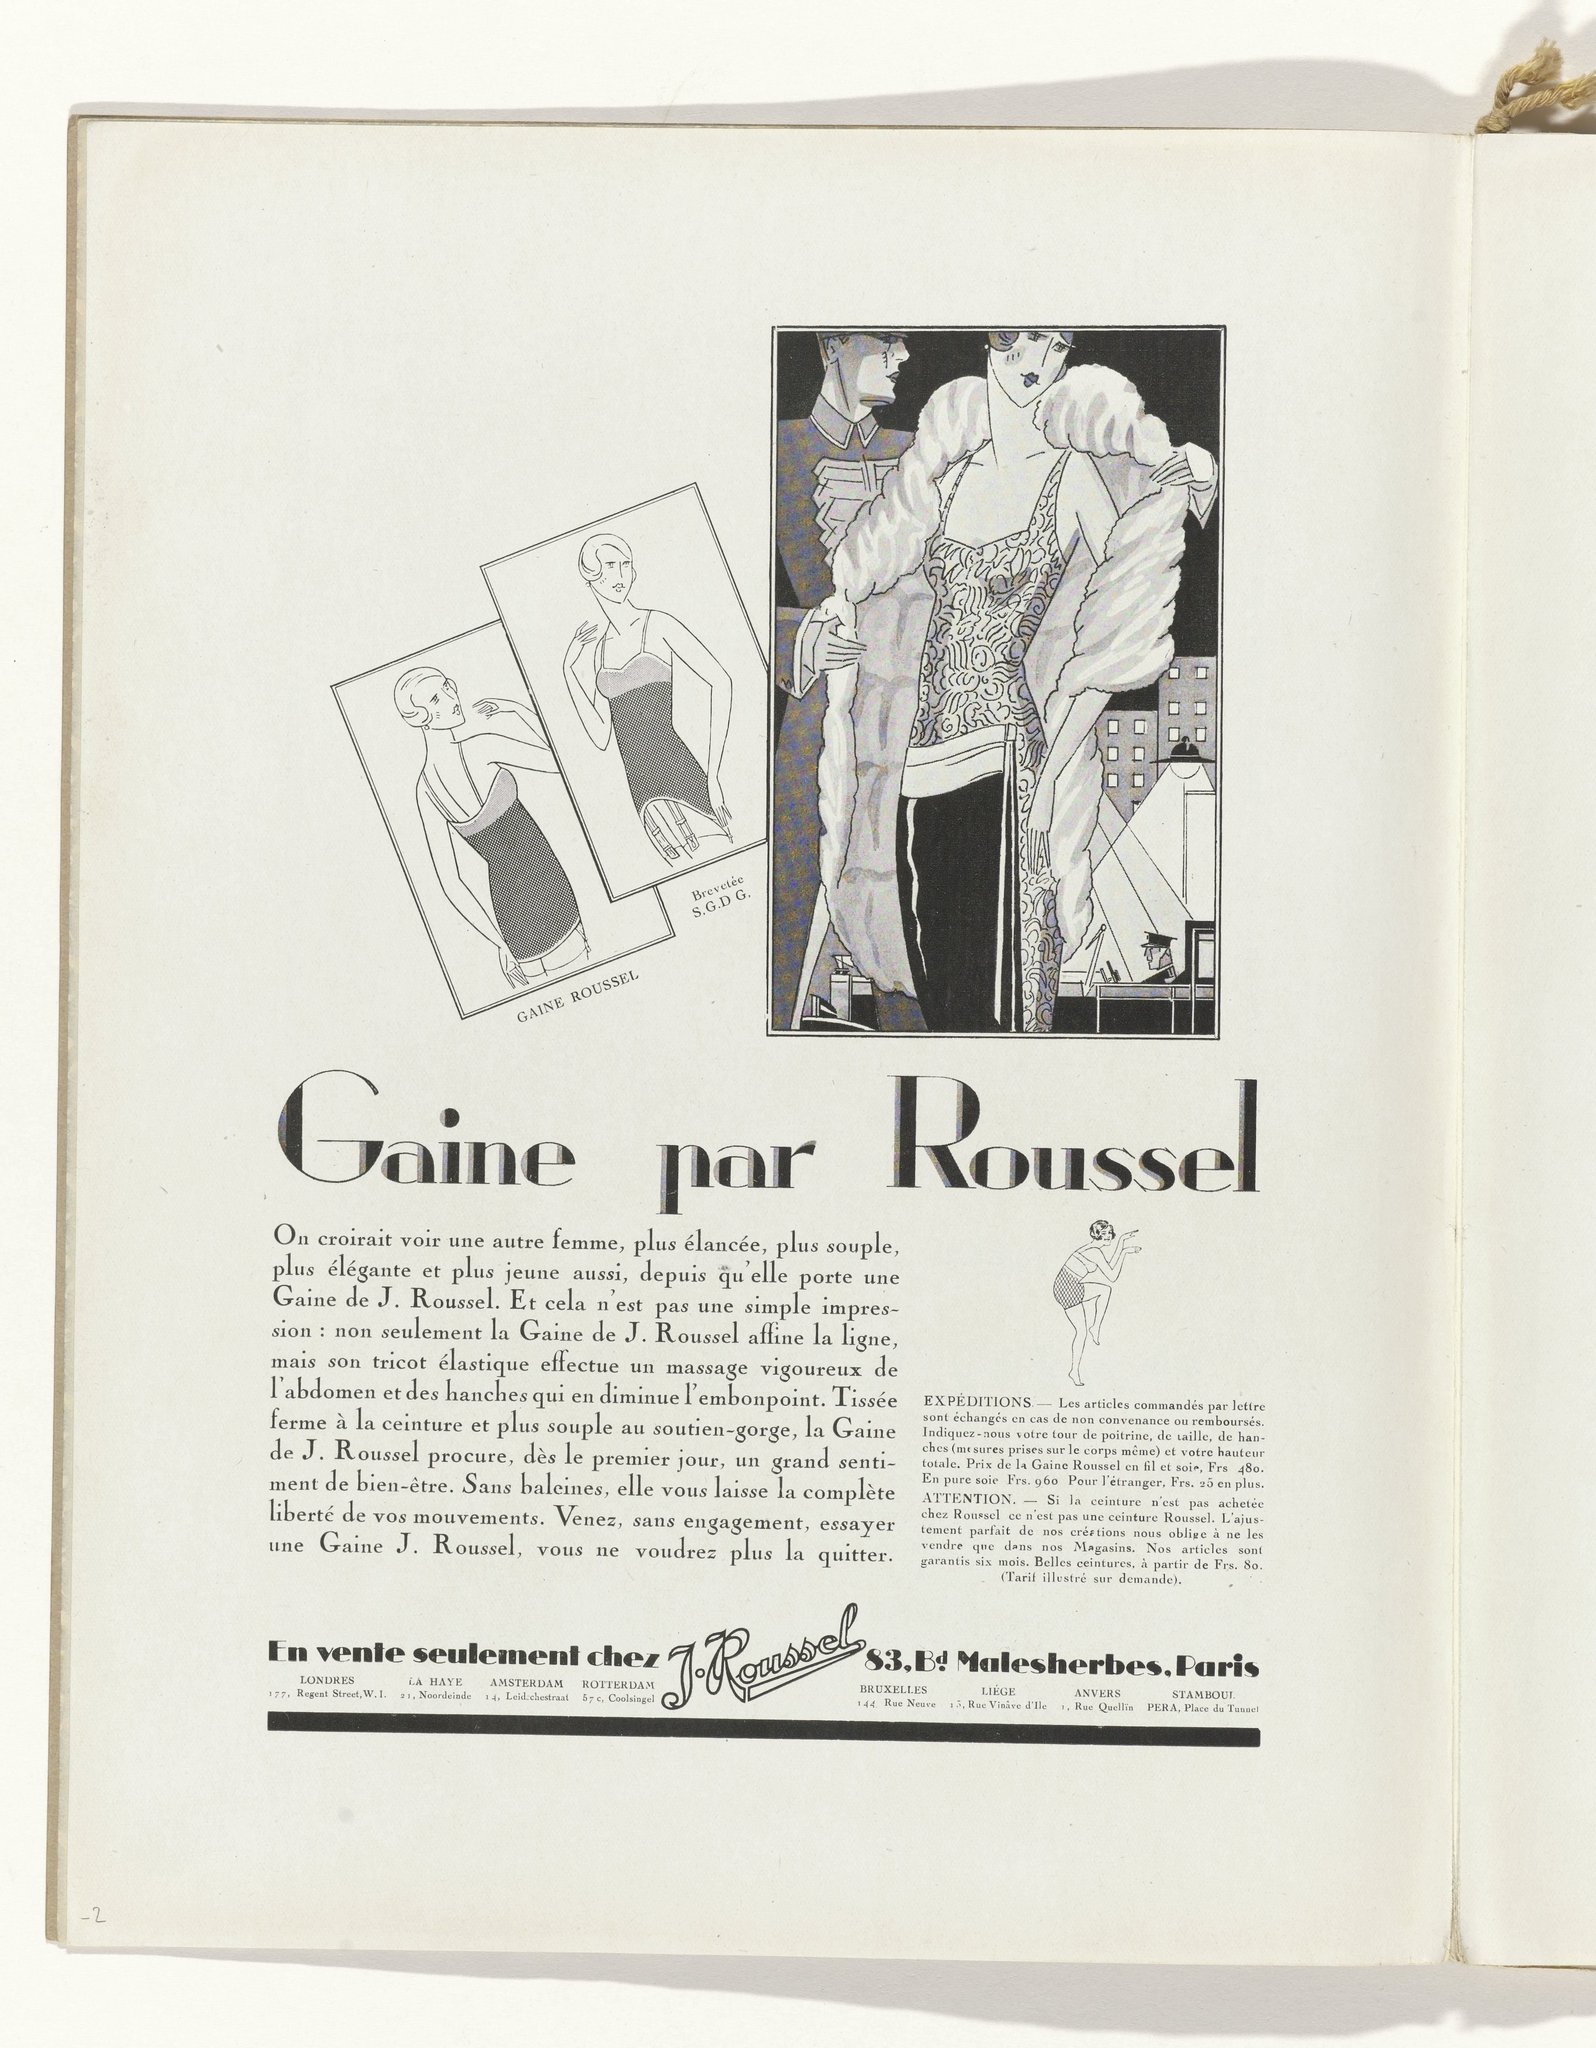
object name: fashion print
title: Art - Goût - Beauté, Feuillets de l' élégance féminine, Mars 1929, No. 103, 9e Année, p. 2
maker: charles goy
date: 1929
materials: paper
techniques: photography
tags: underclothes for the whole body (+ women's clothes), coat (+ women's clothes), fashion plates, dress, gown (+ women's clothes), automobile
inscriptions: title: ‘Gaine par Roussel’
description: Advertentie voor ondergoed van J. Roussel. Pagina uit het modetijdschrift Art-Goût-Beauté (1920-1933).